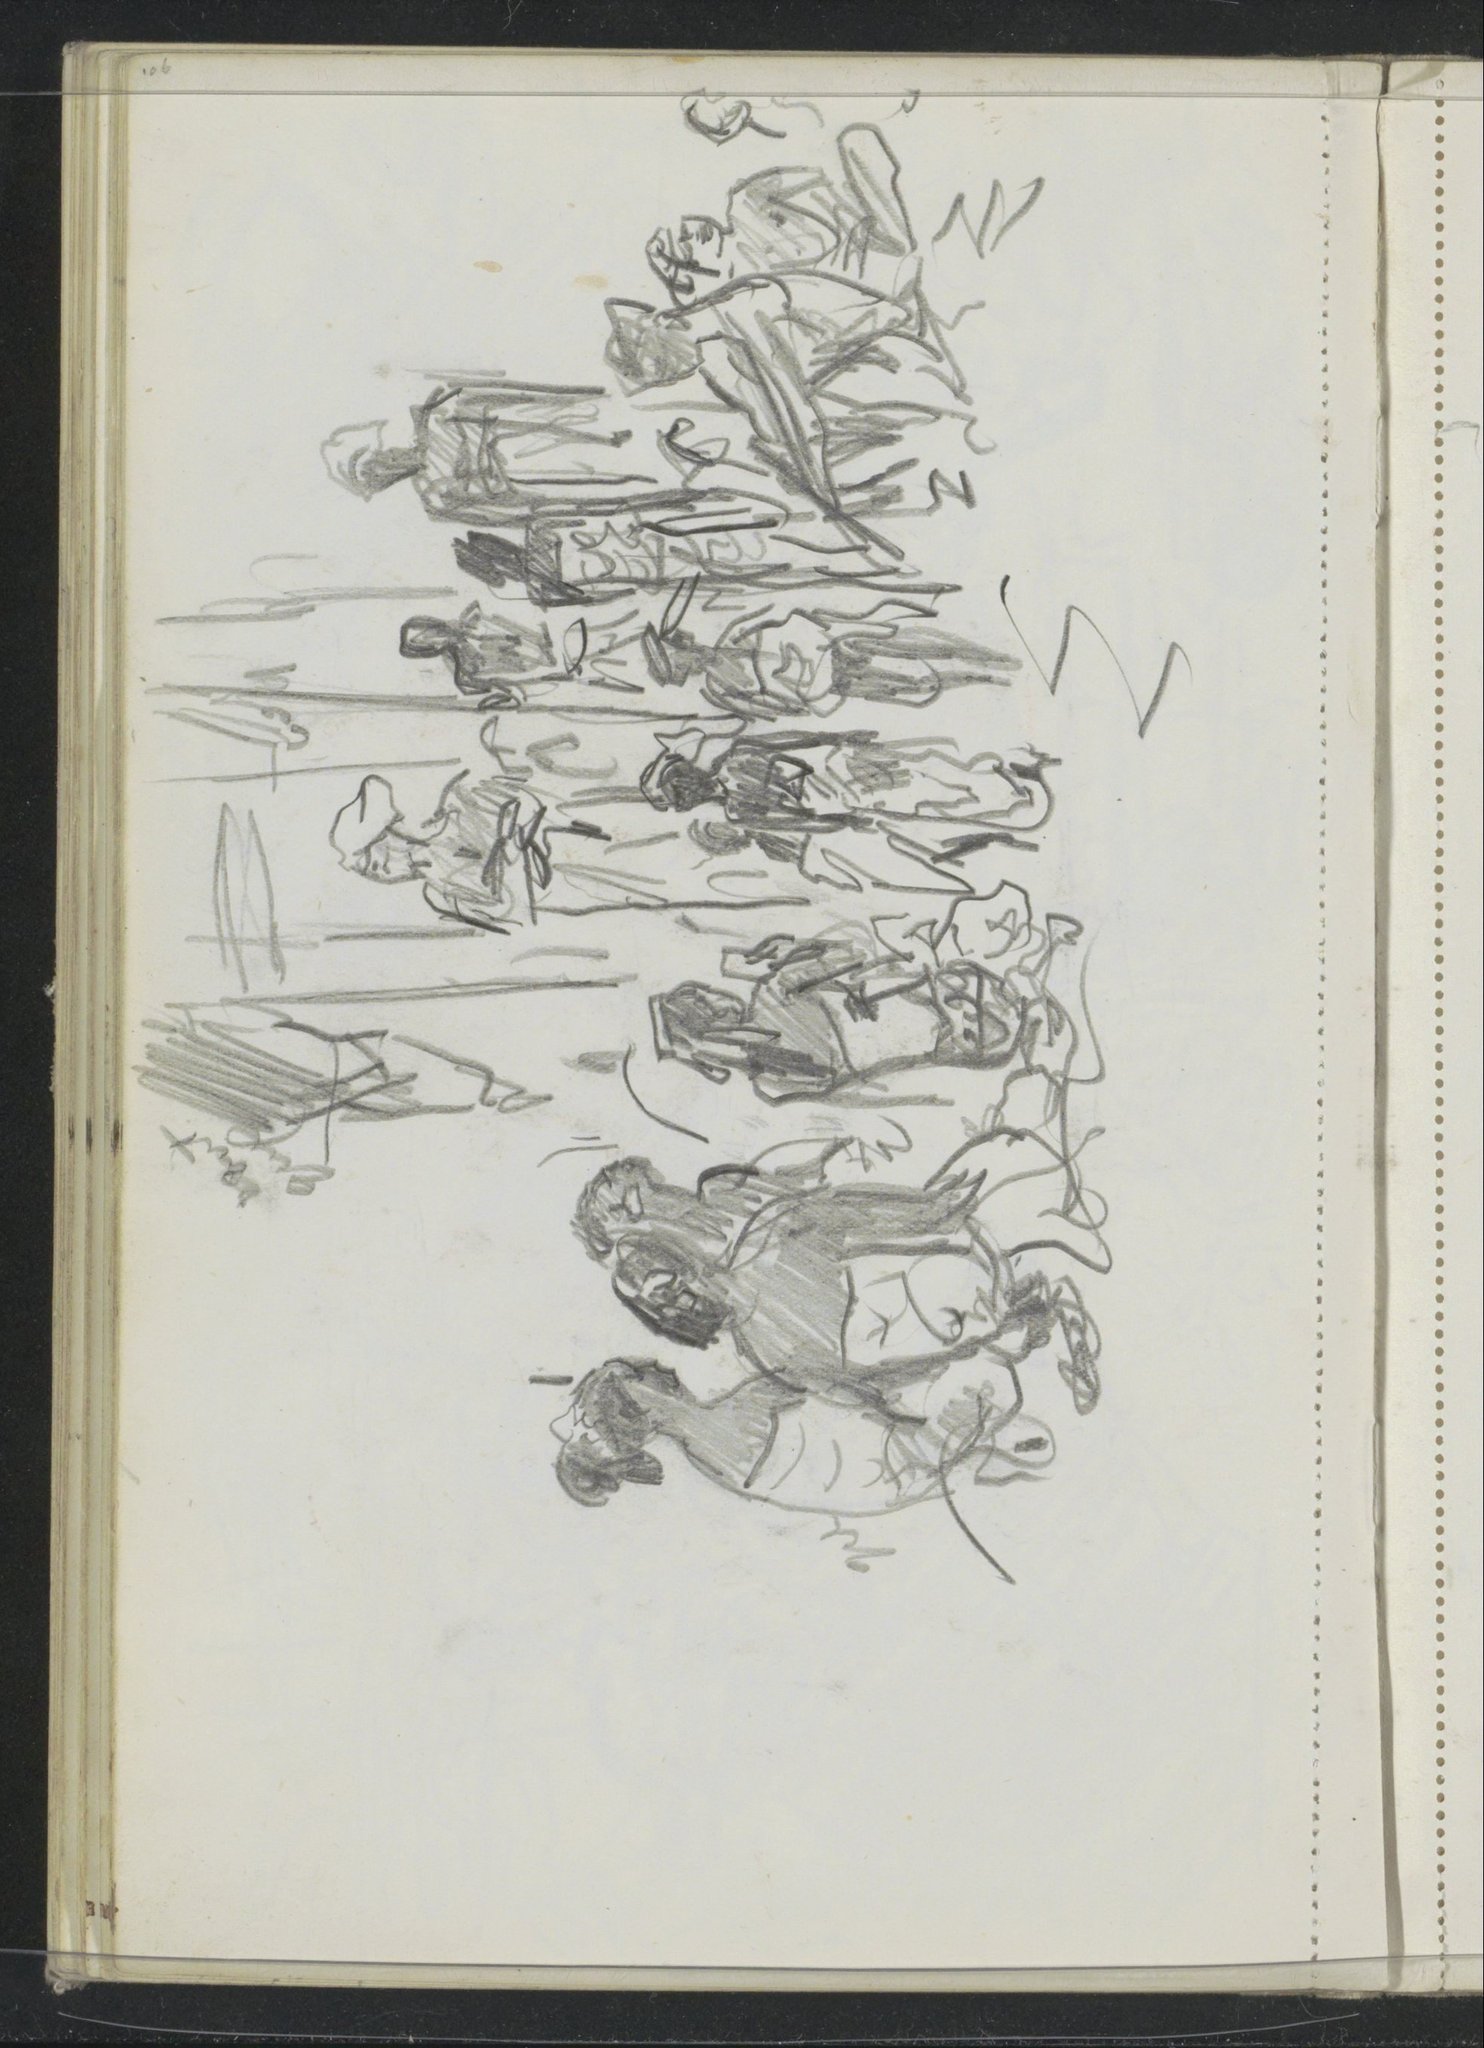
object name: sketchbook leaf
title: Zittende Indonesiërs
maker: marius bauer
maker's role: draughtsman, print maker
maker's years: 1867-1932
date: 1925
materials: paper, pencil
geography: indonesia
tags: asiatic races and peoples, sitting figure, flags (~ signalling), parasol, sunshade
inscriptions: kleurnotitie, handgeschreven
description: De figuren zitten rondom enkele figuren met vlaggen en parasols. Pagina 106 uit een schetsboek met 74 bladen.